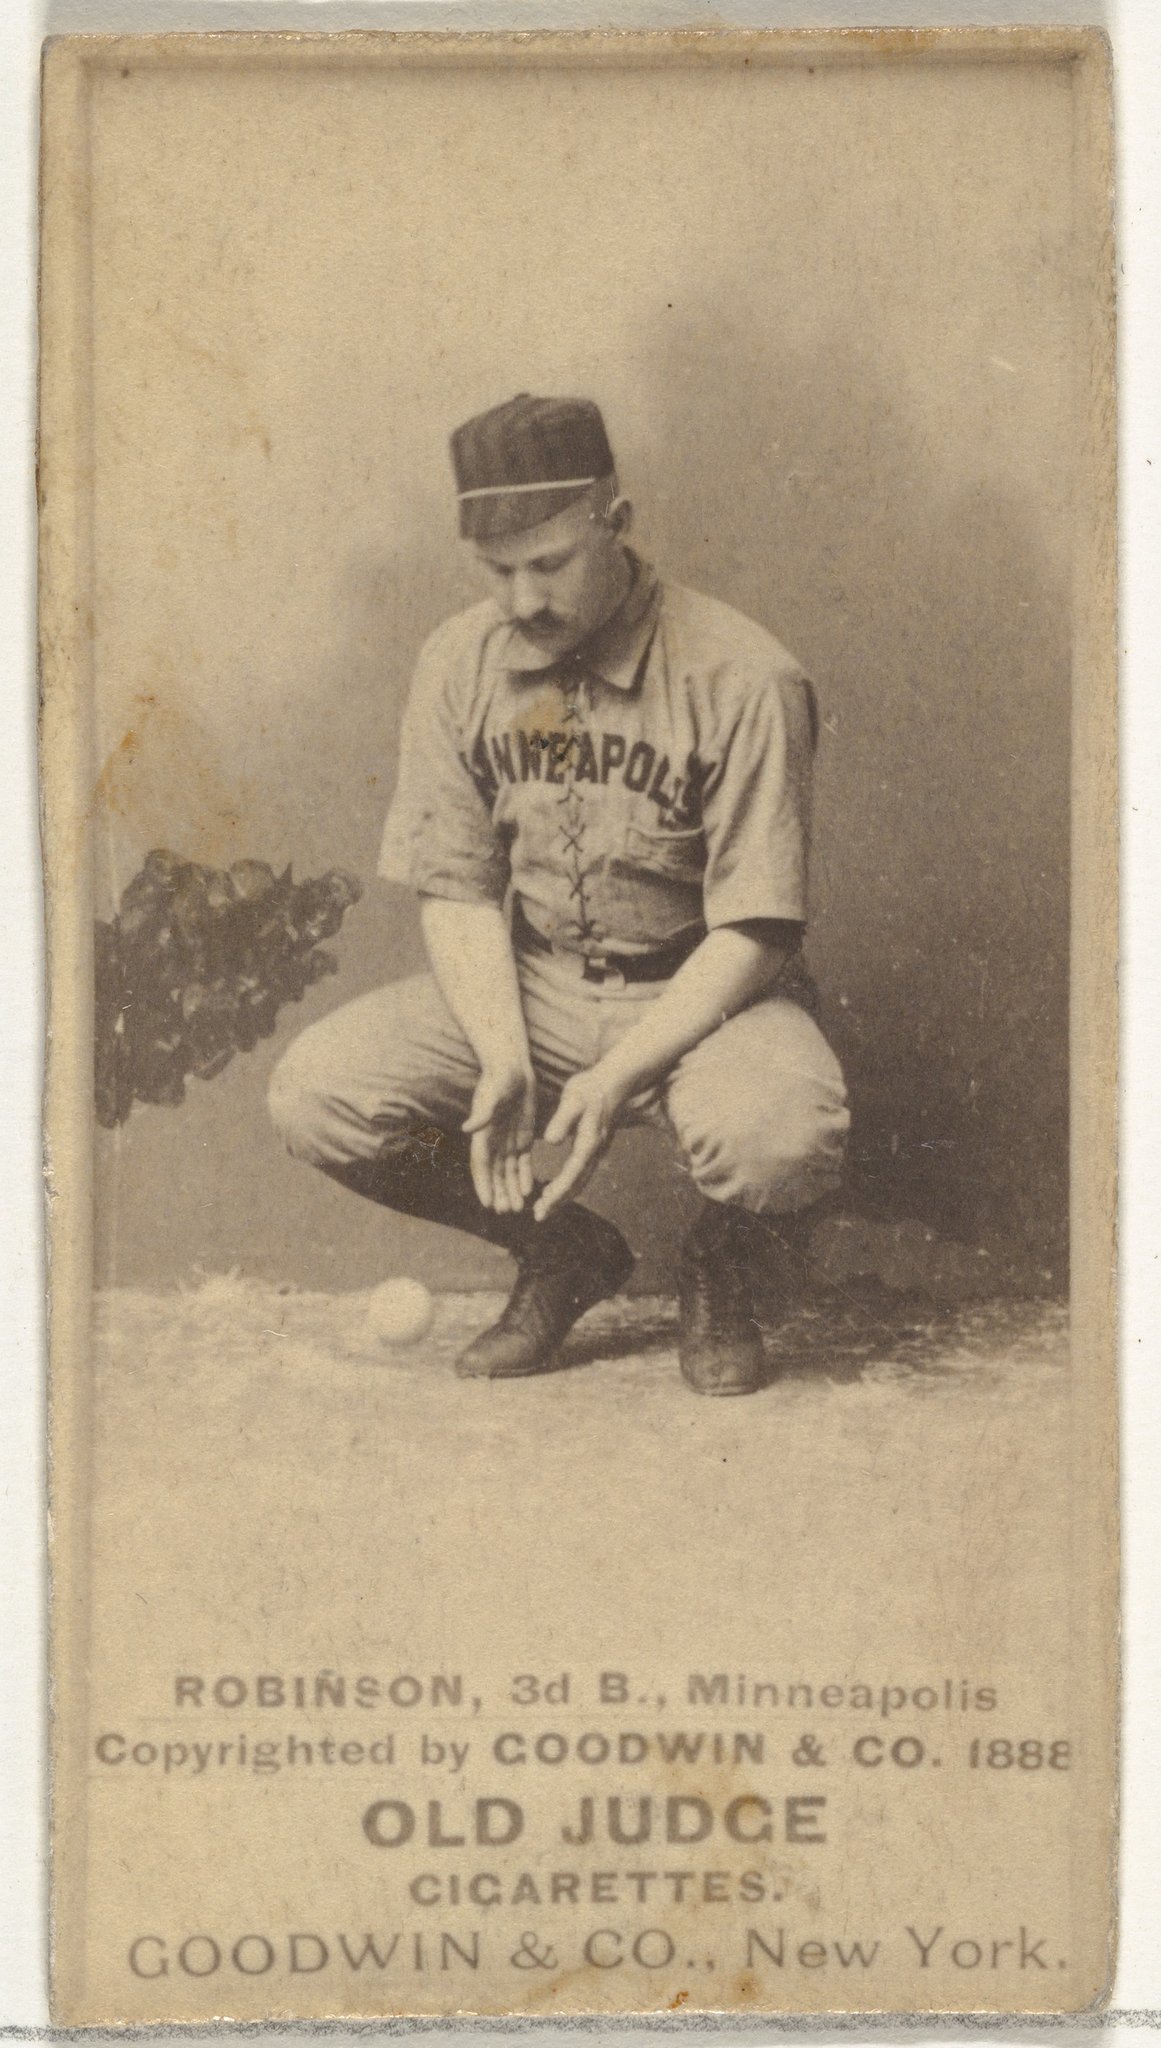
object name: baseball card, photograph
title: Myers C. Robinson, 3rd Base, Minneapolis, from the Old Judge series (N172) for Old Judge Cigarettes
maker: goodwin & company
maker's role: publisher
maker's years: 1850-1950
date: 1888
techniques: albumen silver print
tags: men,portraits,baseball,athletes